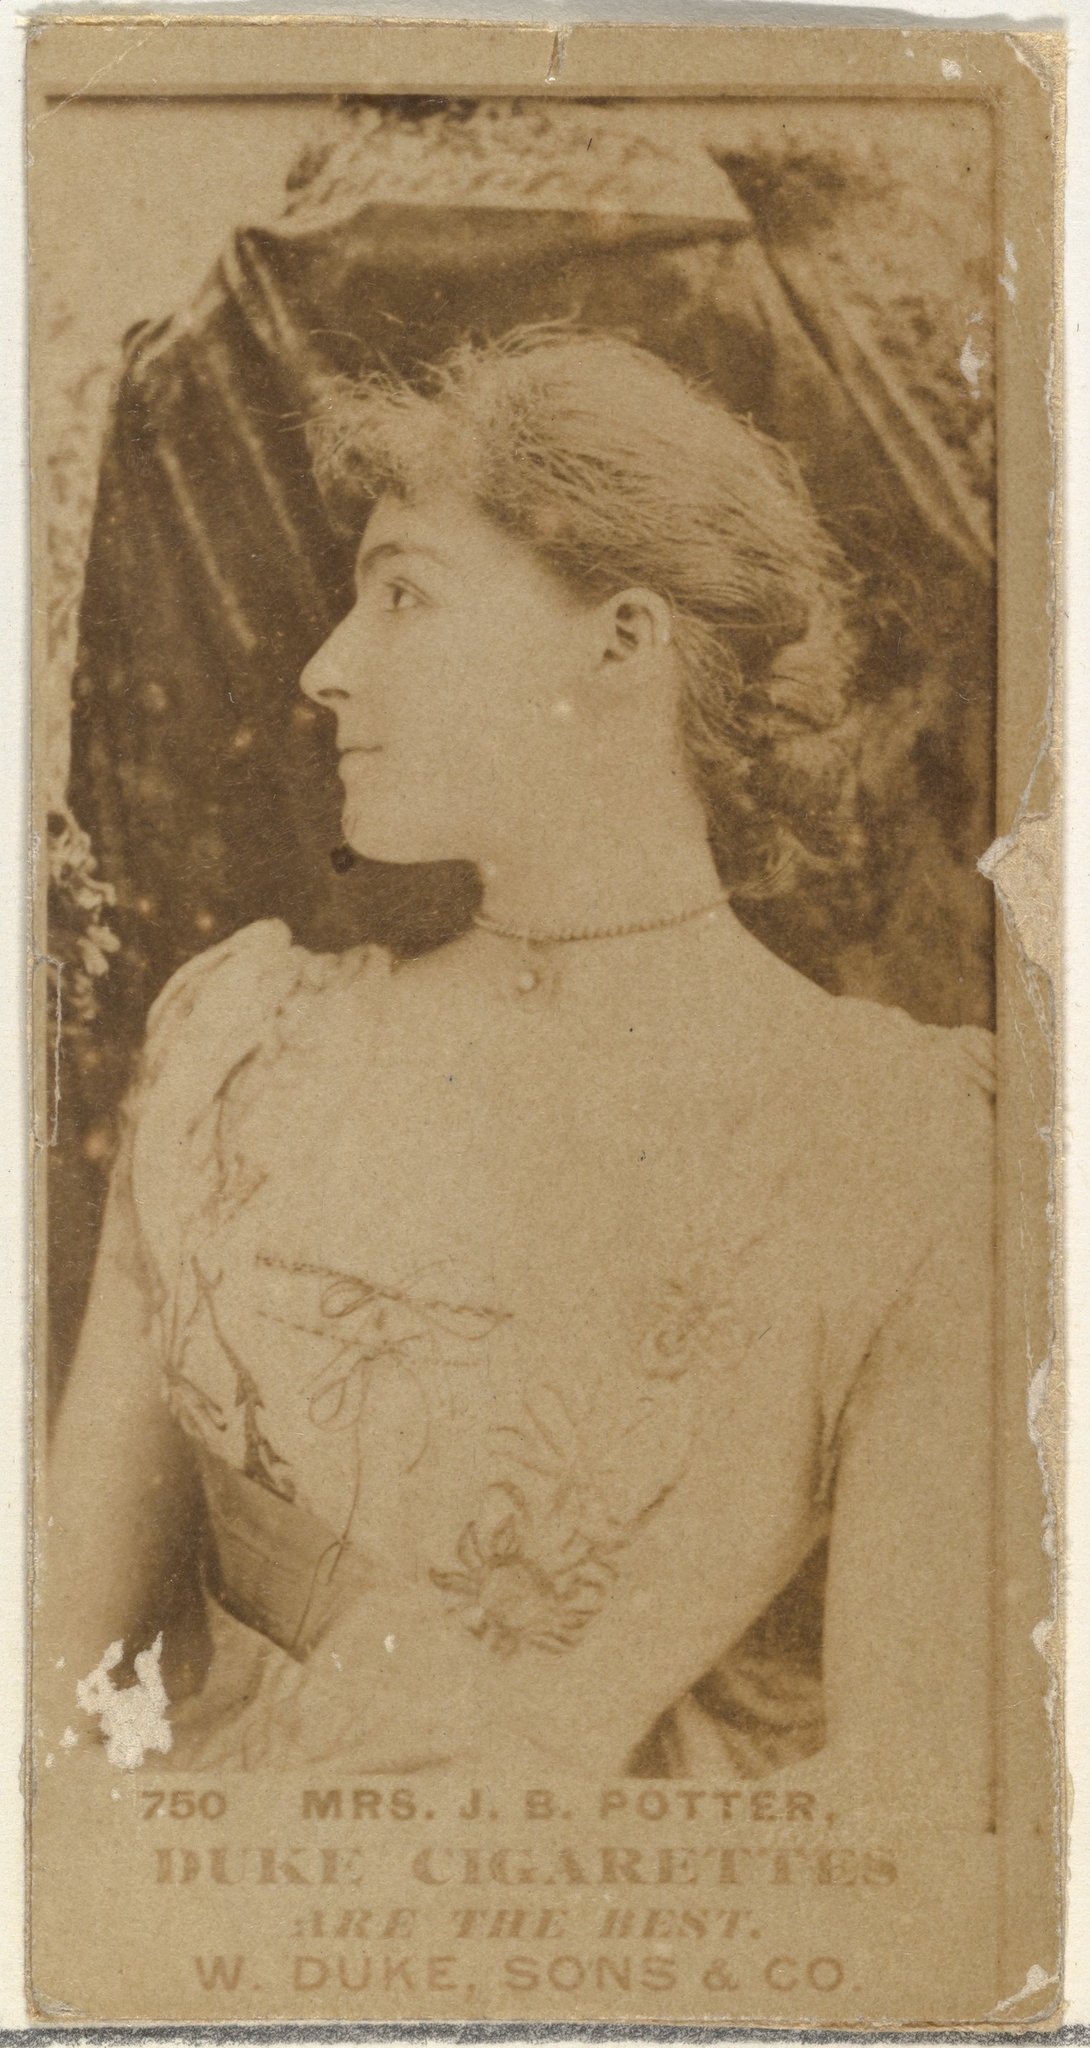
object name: photograph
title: Card Number 750, Mrs. James Brown Potter, from the Actors and Actresses series (N145-7) issued by Duke Sons & Co. to promote Duke Cigarettes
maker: w. duke, sons & co.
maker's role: publisher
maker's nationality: american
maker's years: 1870-1920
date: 1880-1889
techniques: albumen silver print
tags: women,actresses